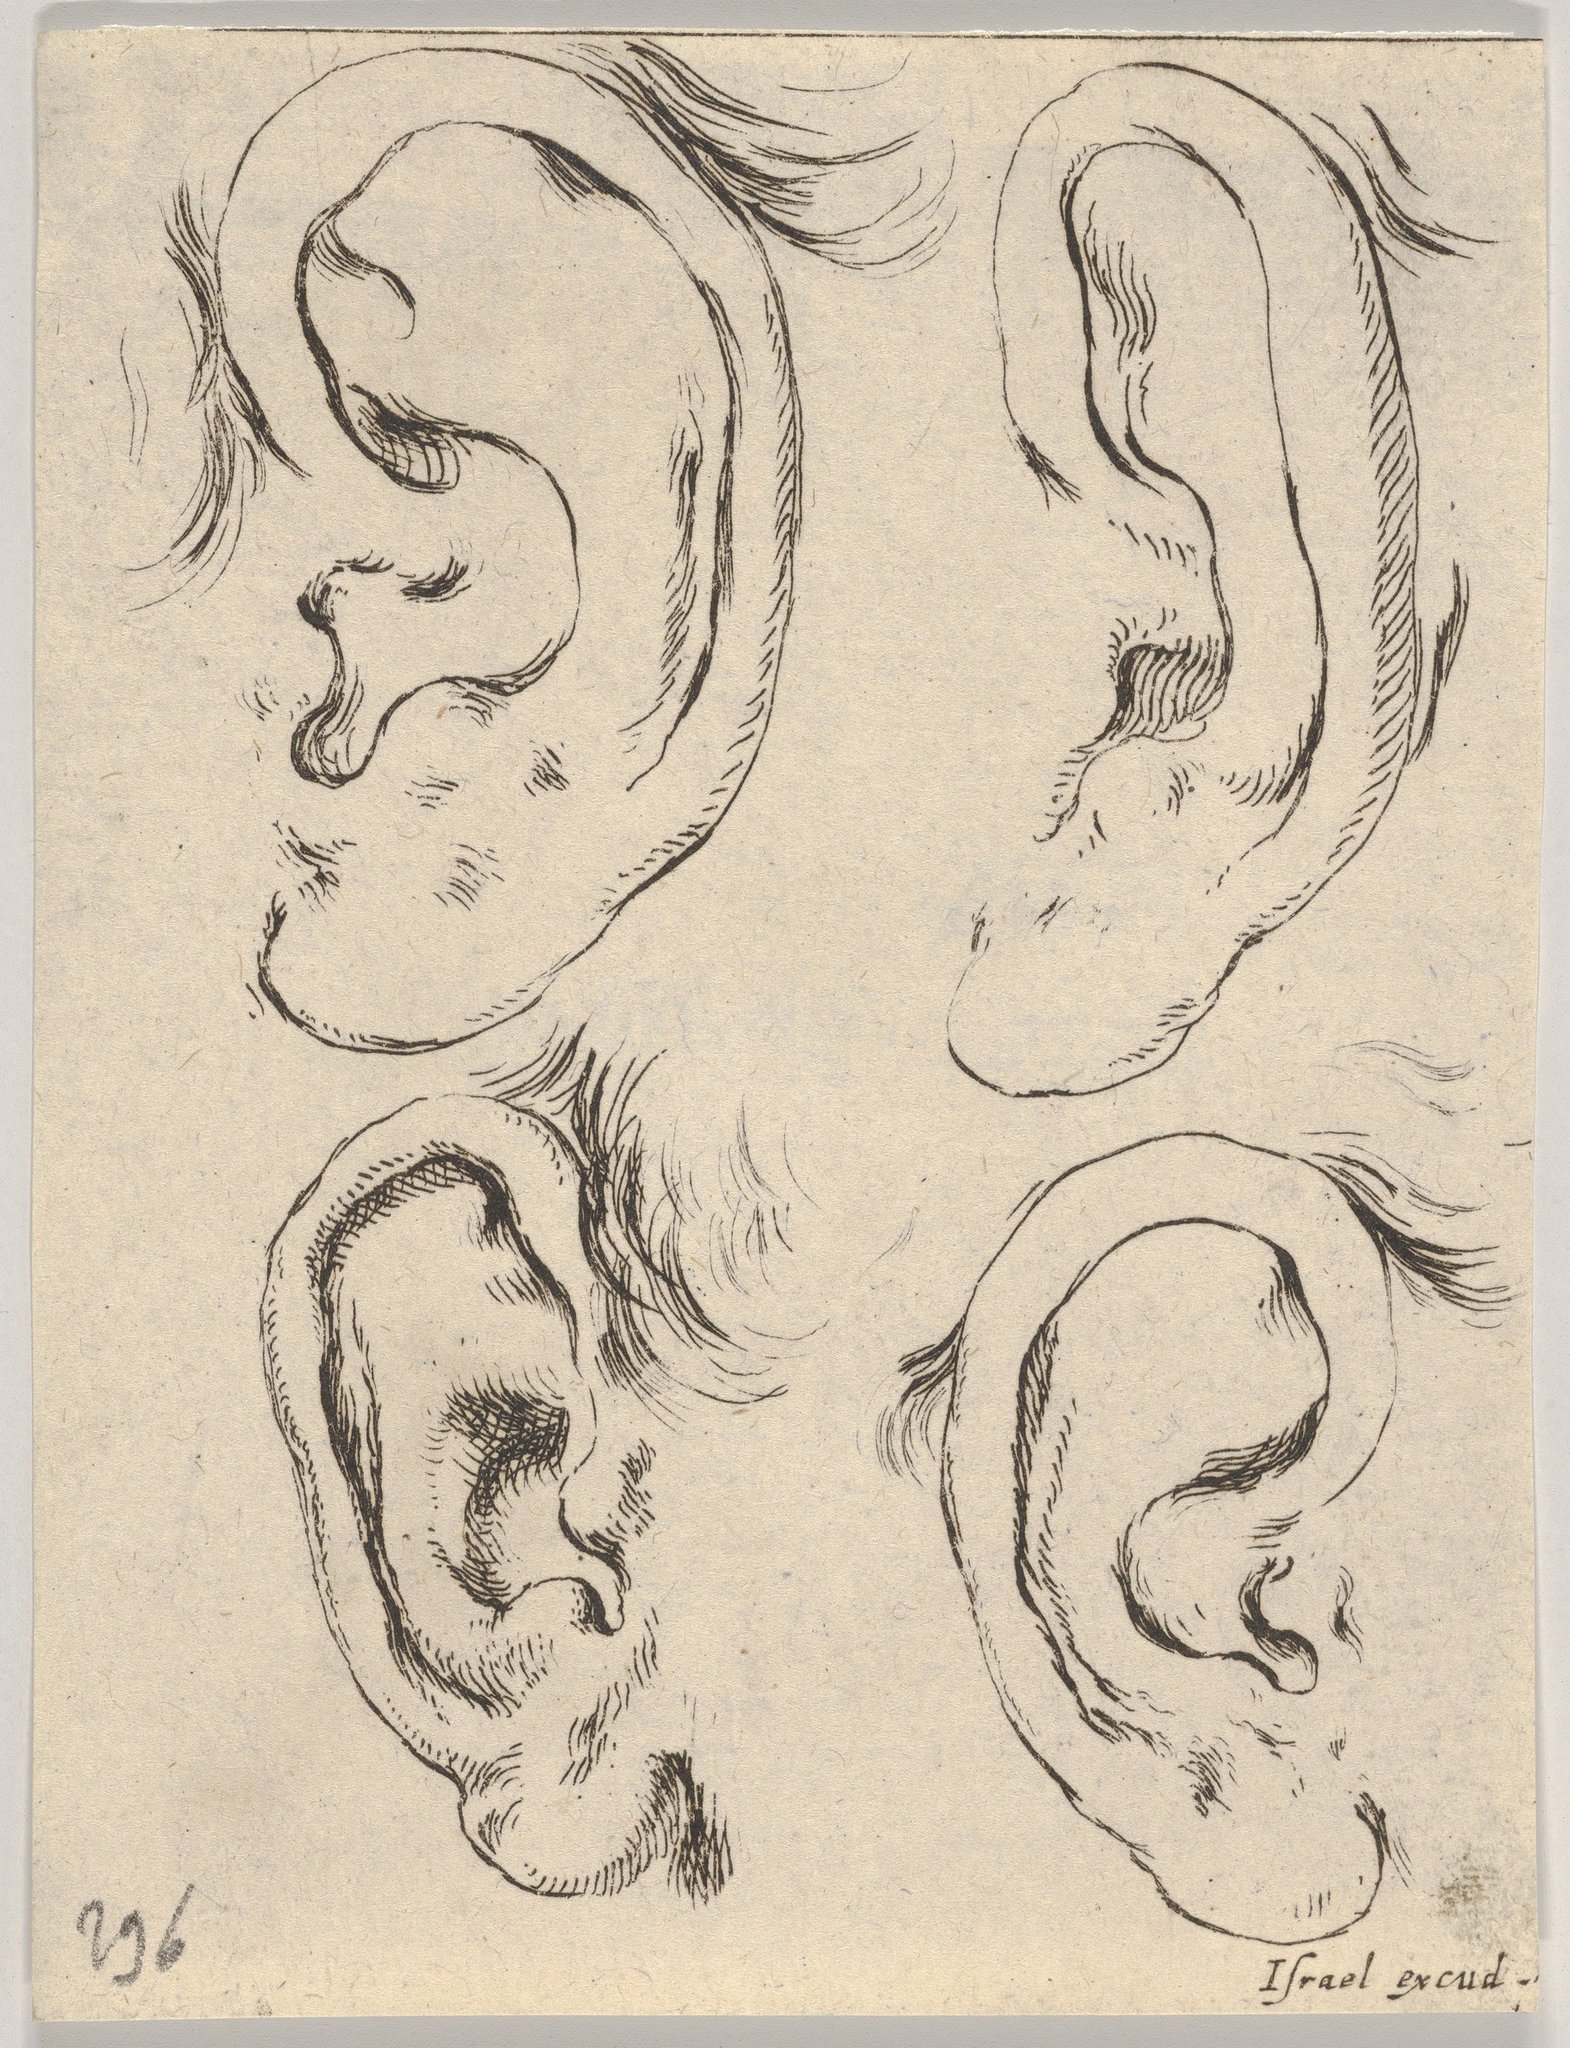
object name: print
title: Plate 5: Four ears, from "The Book for Learning to Draw" (Livre pour apprendre à dessiner)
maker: stefano della bella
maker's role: artist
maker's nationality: italian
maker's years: 1610-1664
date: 1649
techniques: etching